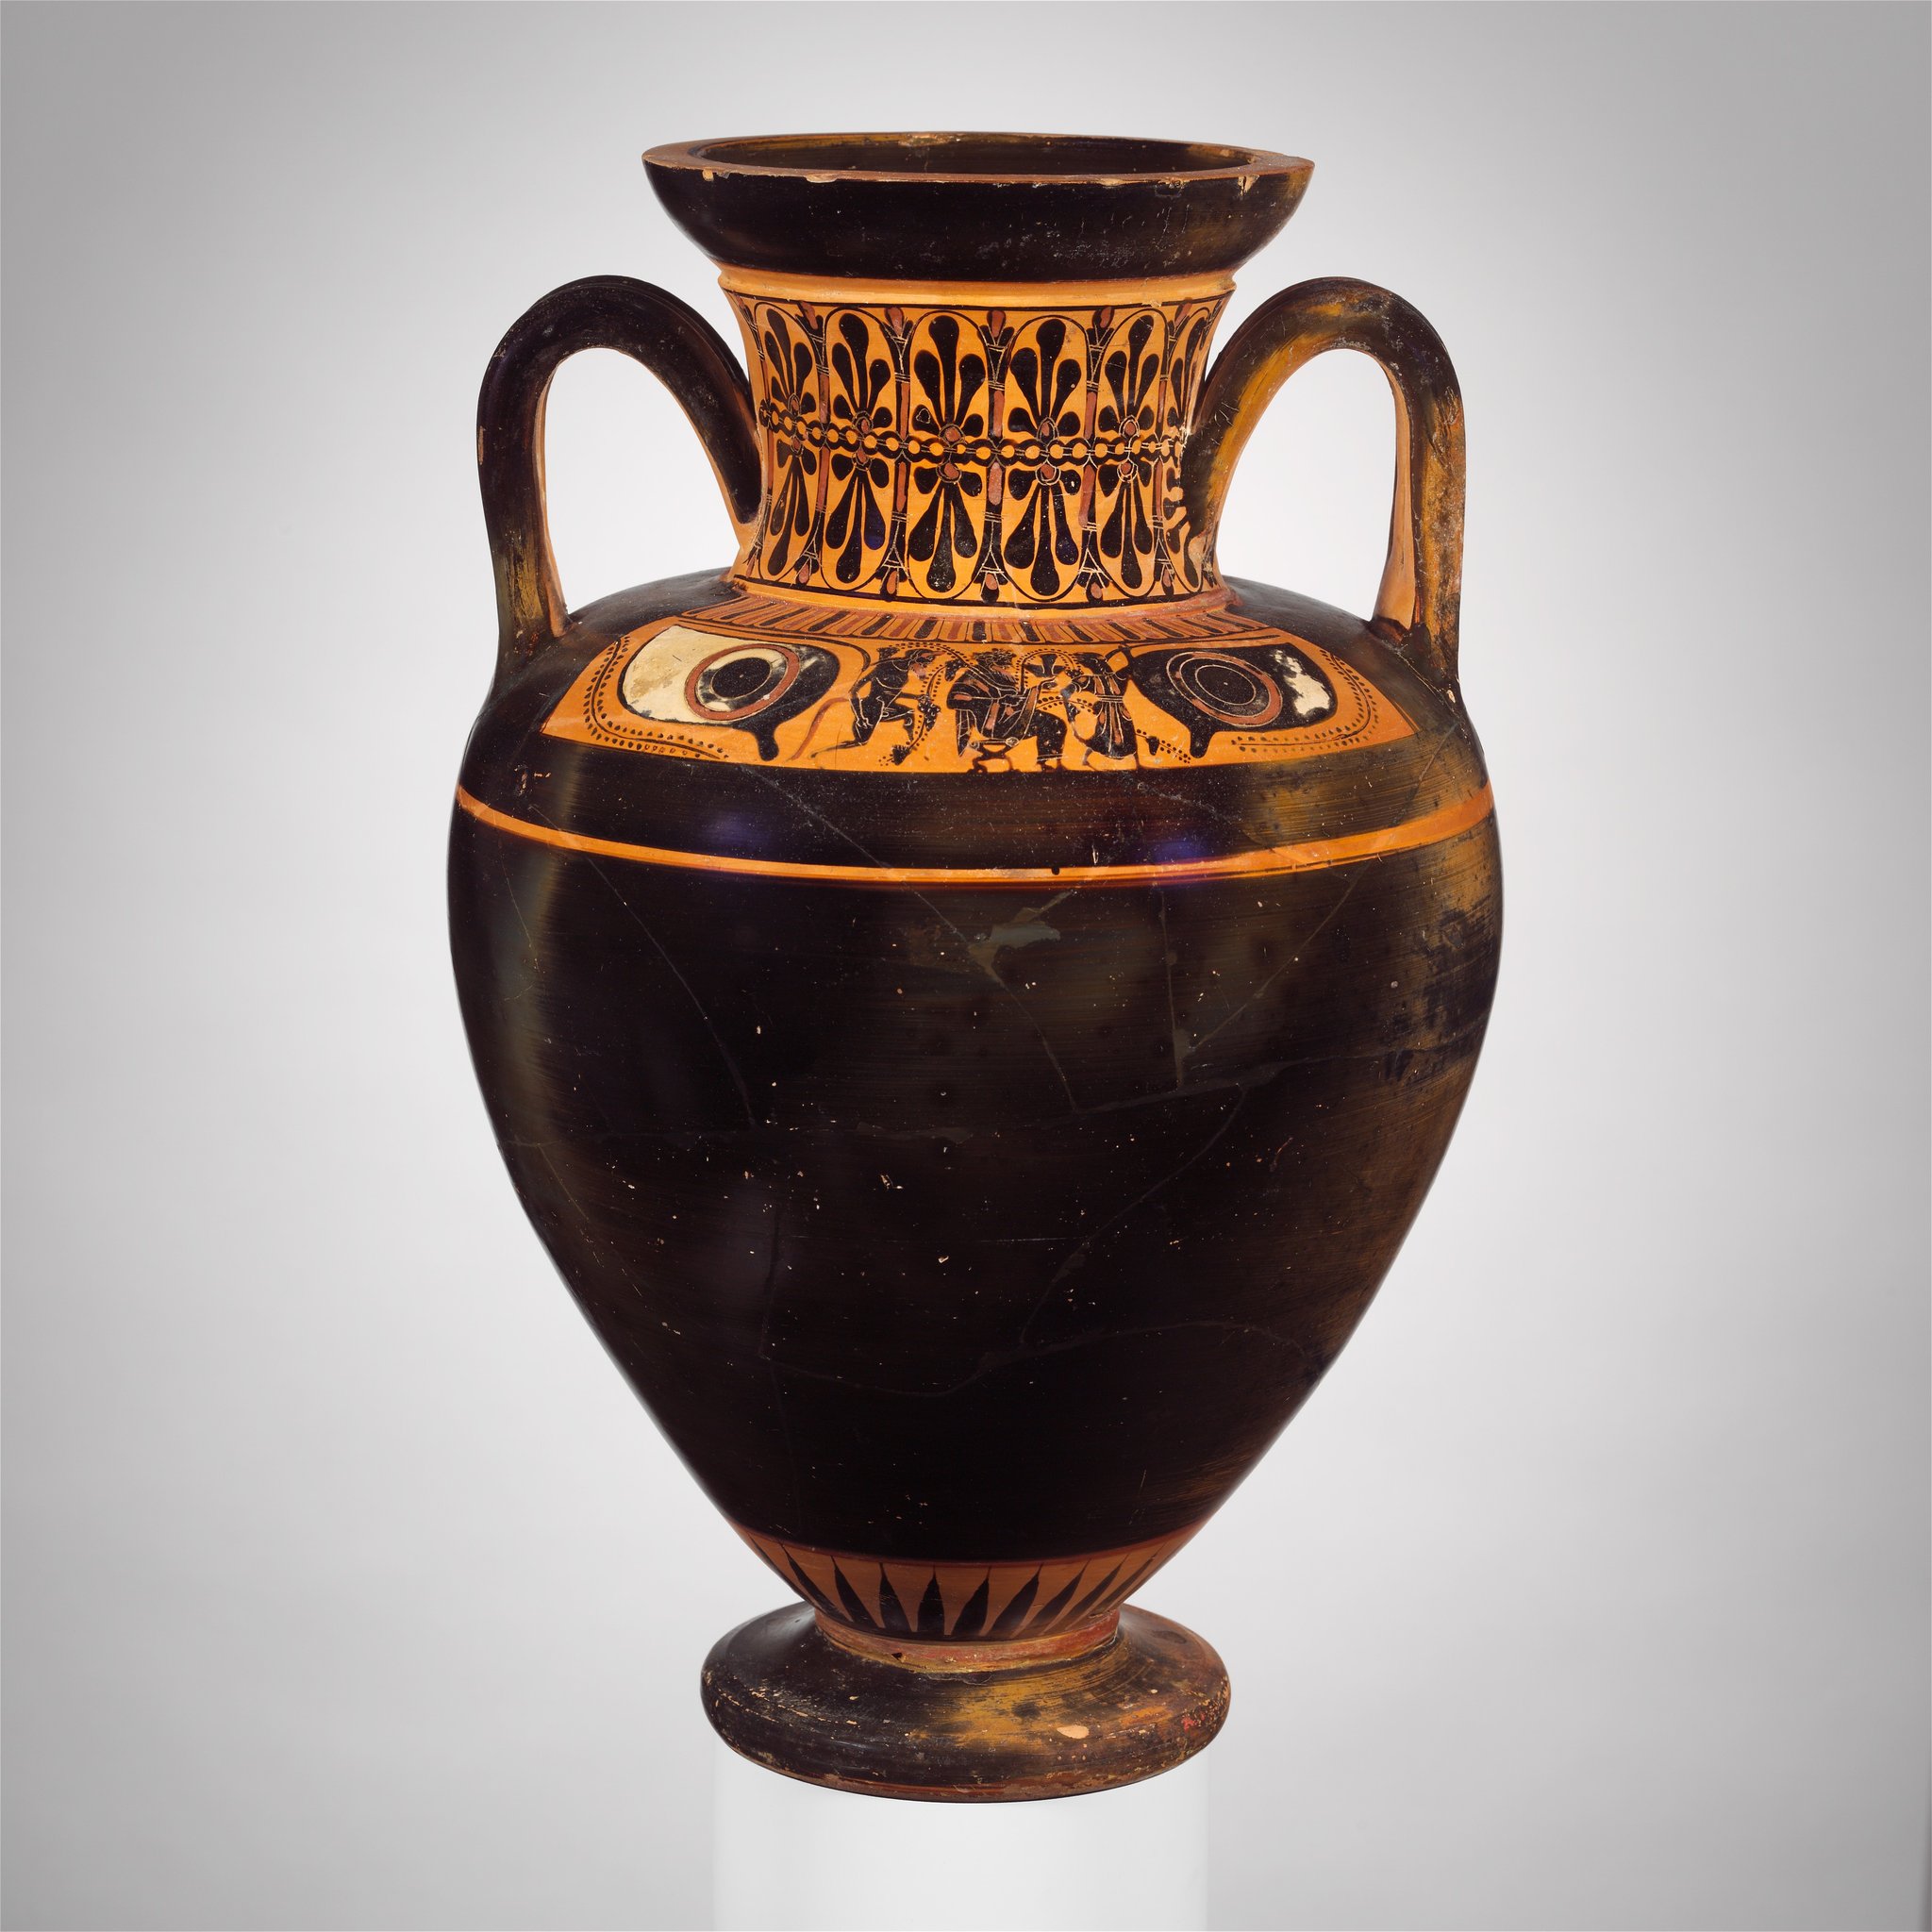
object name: neck amphora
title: Terracotta neck-amphora (jar)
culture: greek, attic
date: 525-501 BCE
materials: terracotta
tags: dionysus,maenads,satyrs